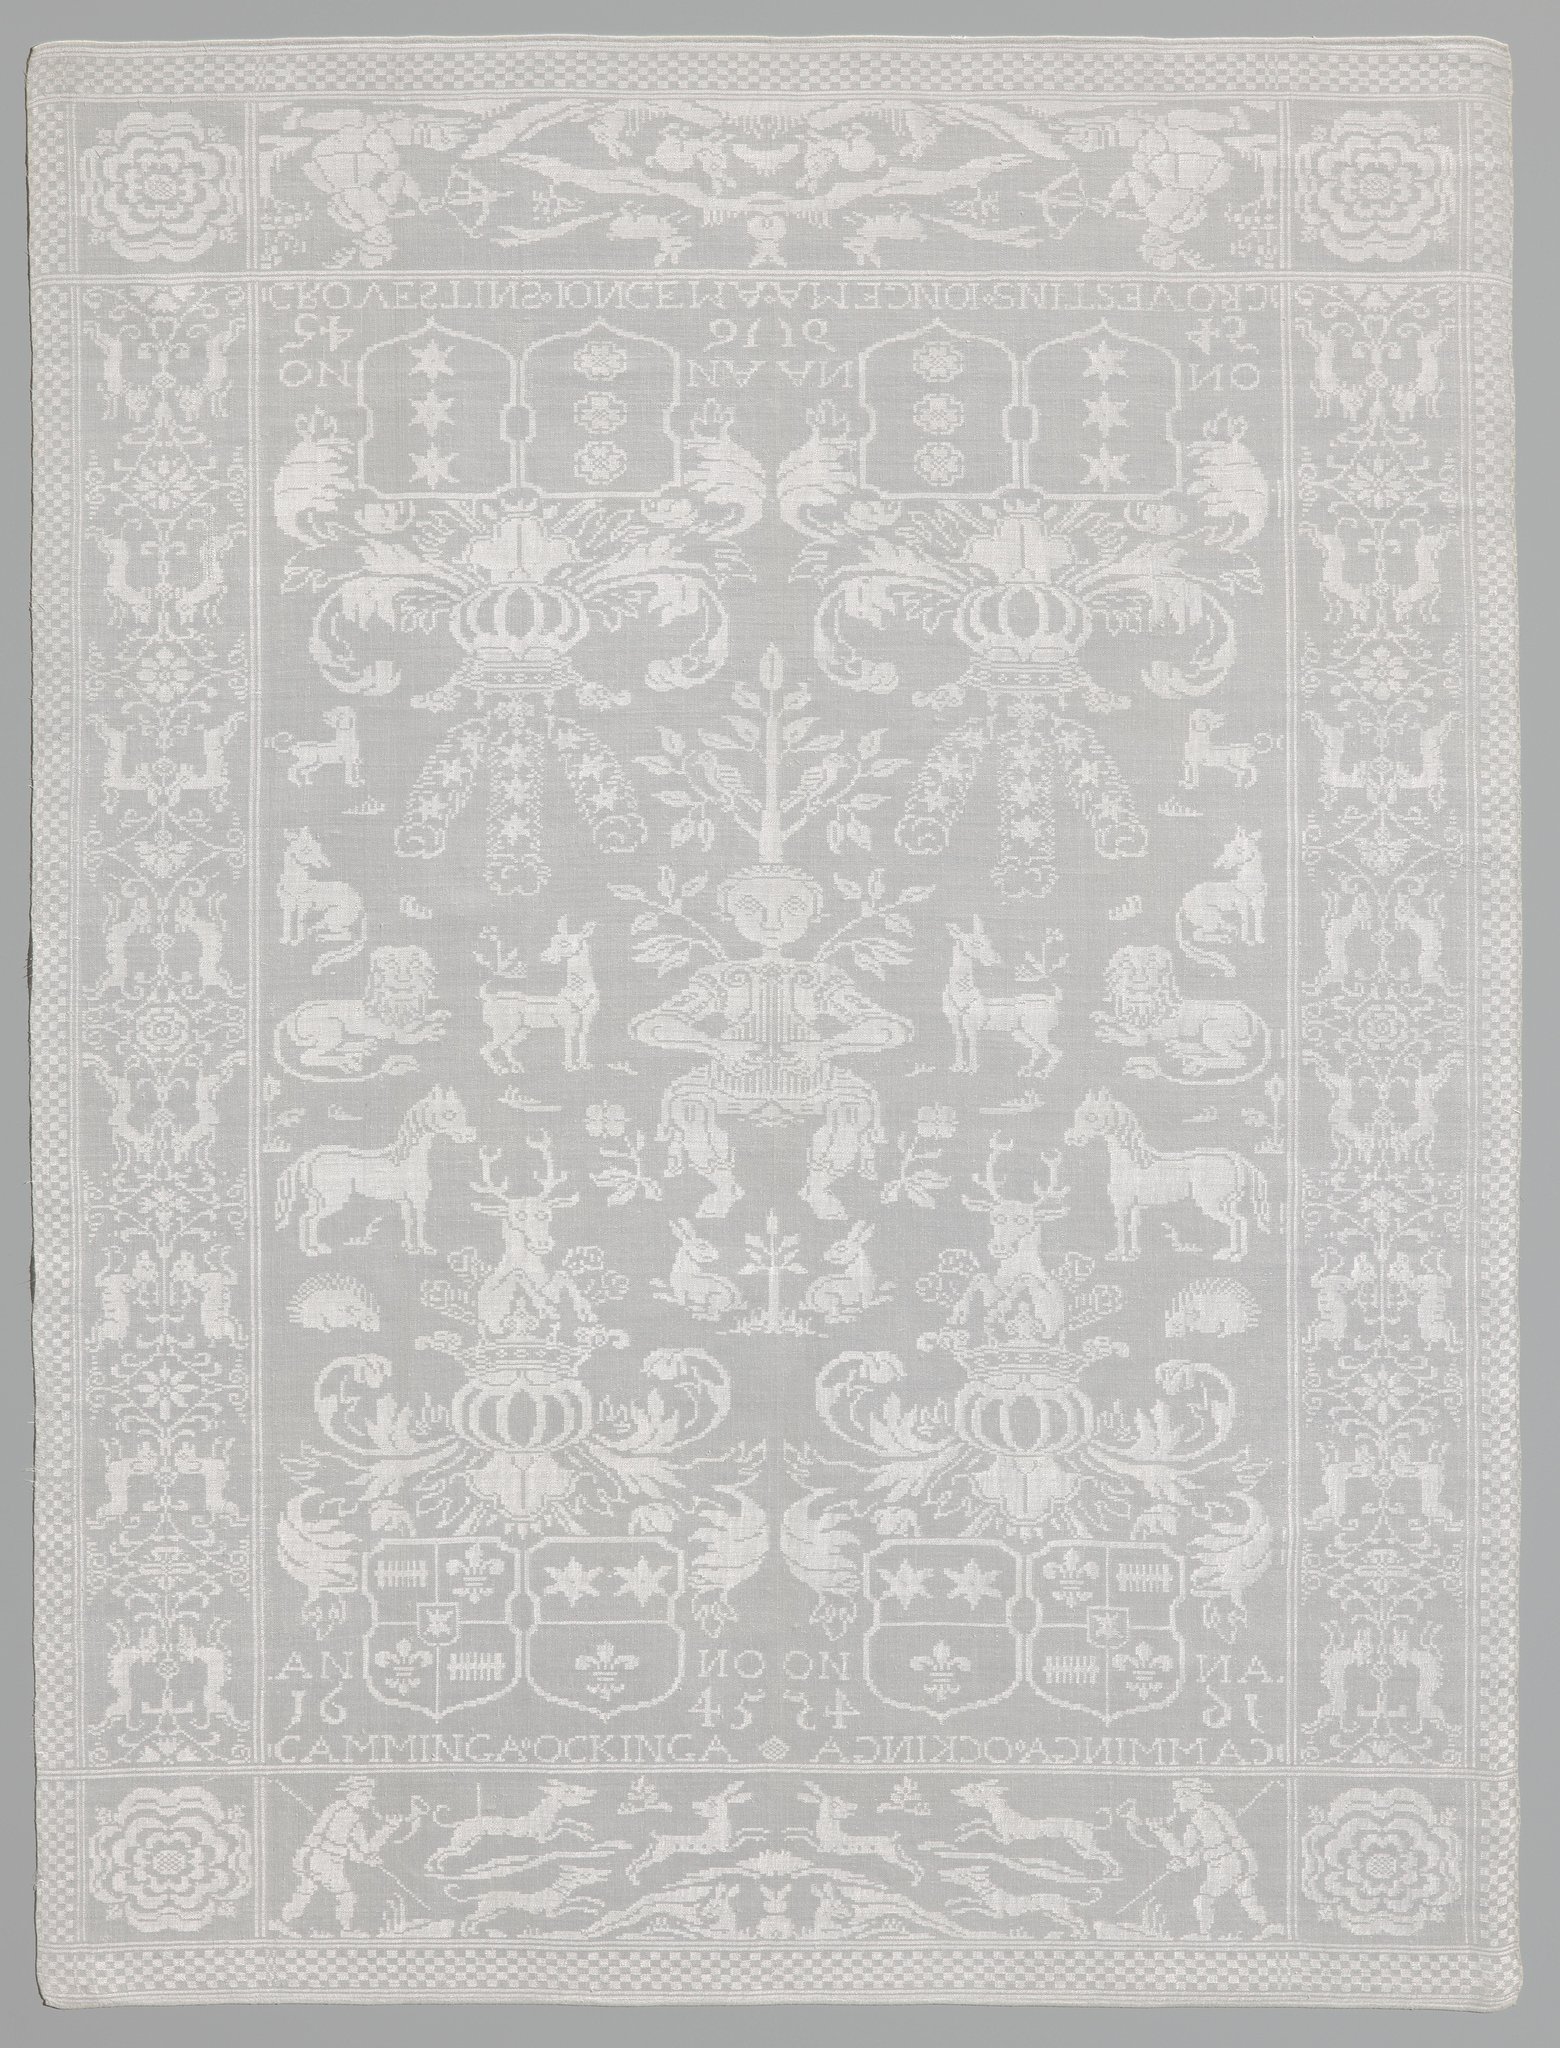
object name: napkin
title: Servet met Friese wapens en Orpheus te midden van de dieren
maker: quirijn jansz. damast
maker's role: mayor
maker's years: 1580-1638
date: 1645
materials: linen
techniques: damask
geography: haarlem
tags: orpheus playing the lyre: trees and rocks move, beasts and birds are enchanted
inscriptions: date